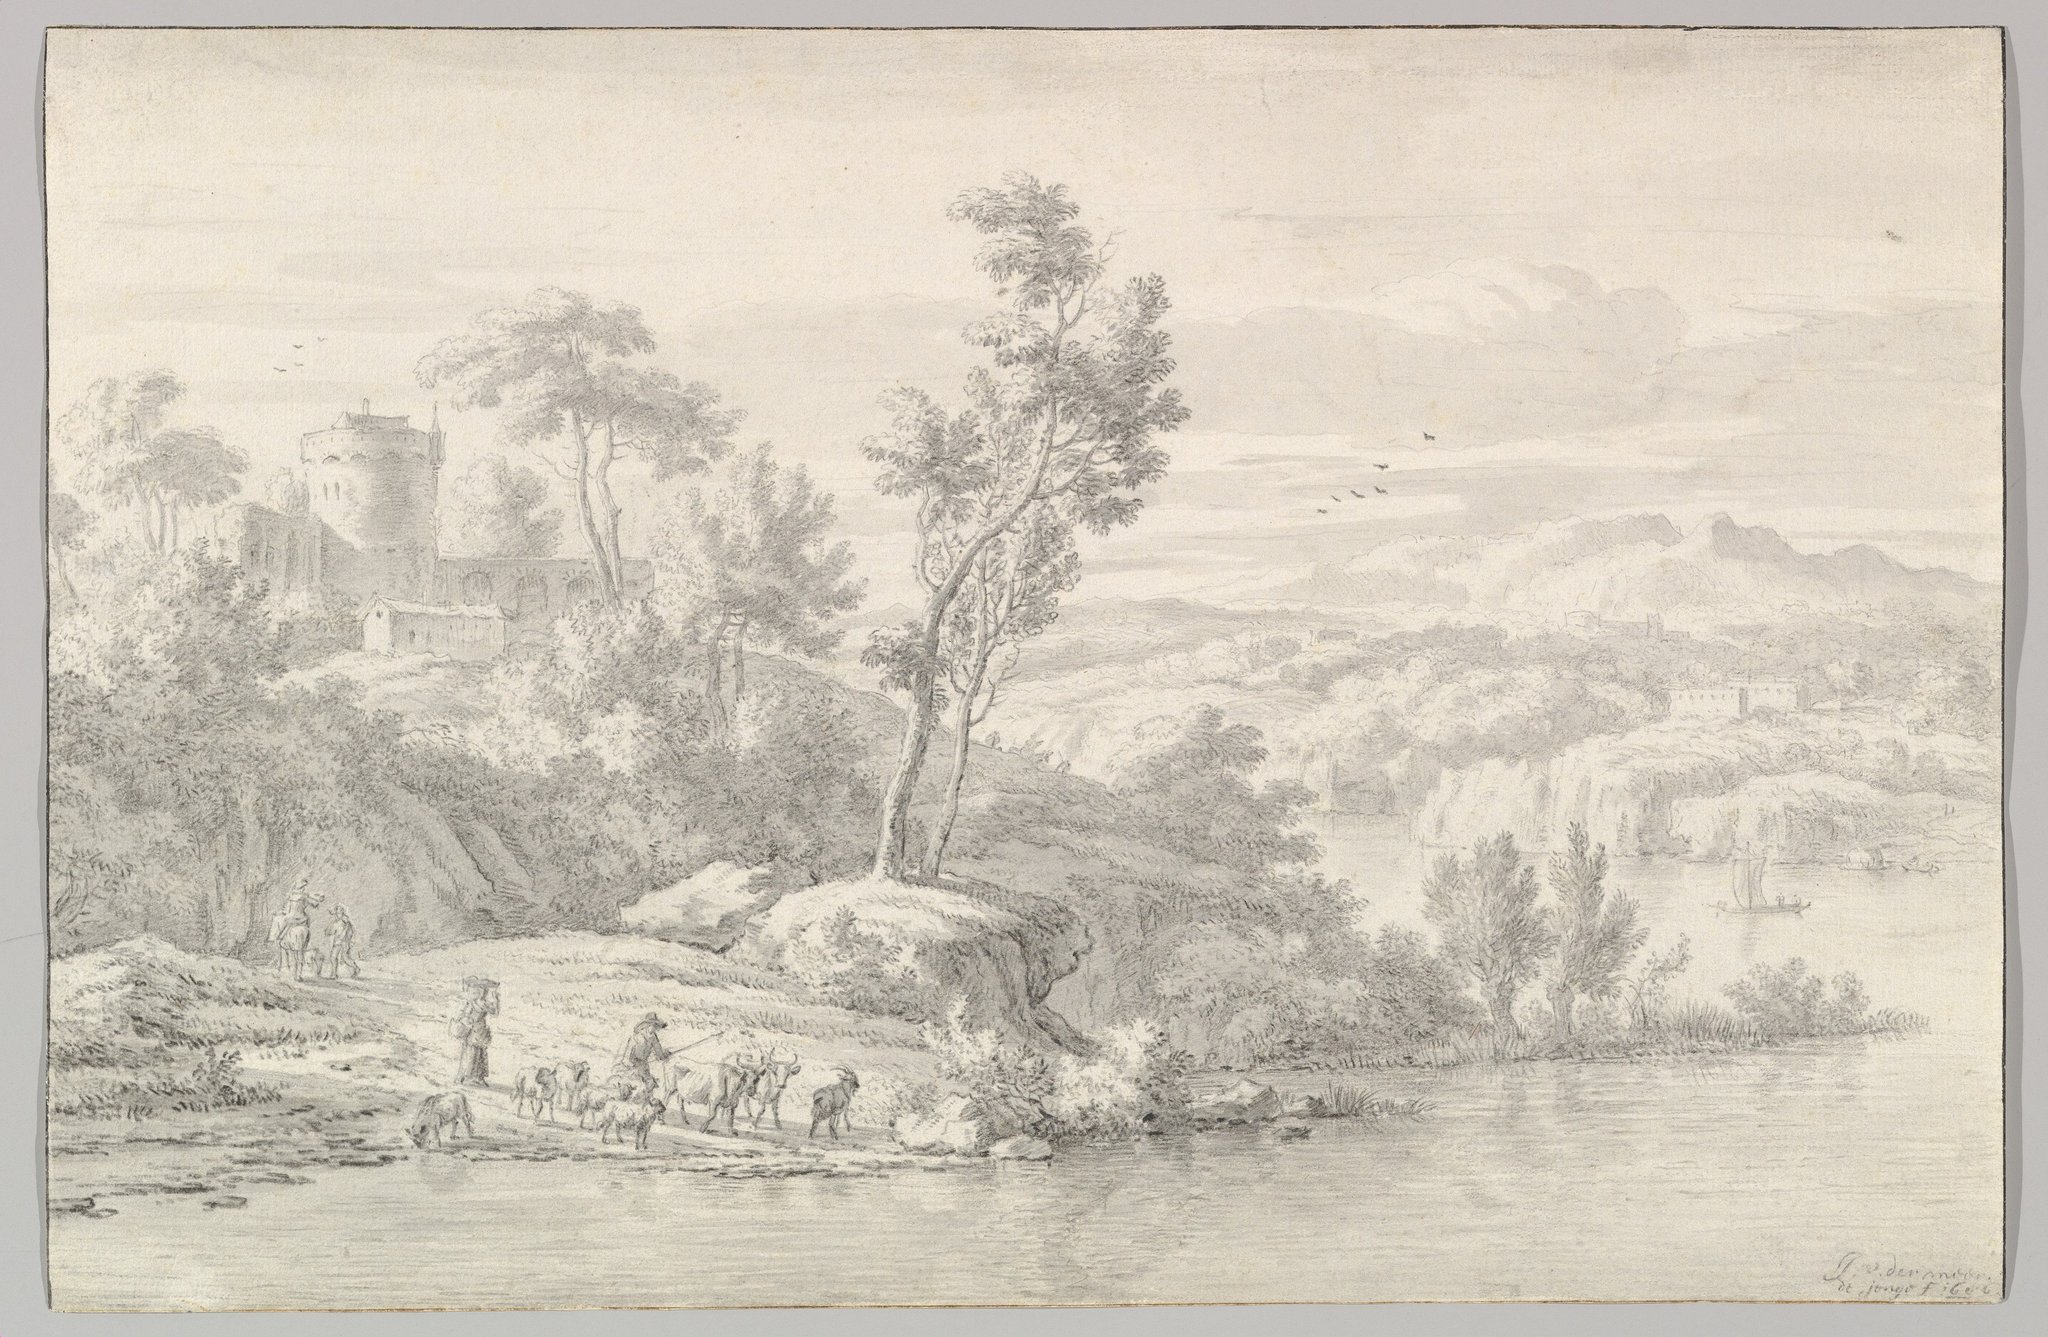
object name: drawing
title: Southern Landscape with Figures and Cattle at a River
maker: jan van der meer the younger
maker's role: artist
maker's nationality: dutch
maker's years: 1656-1705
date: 1686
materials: chalk, ink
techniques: brush, pen, wash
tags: human figures,animals,rivers,landscapes,trees